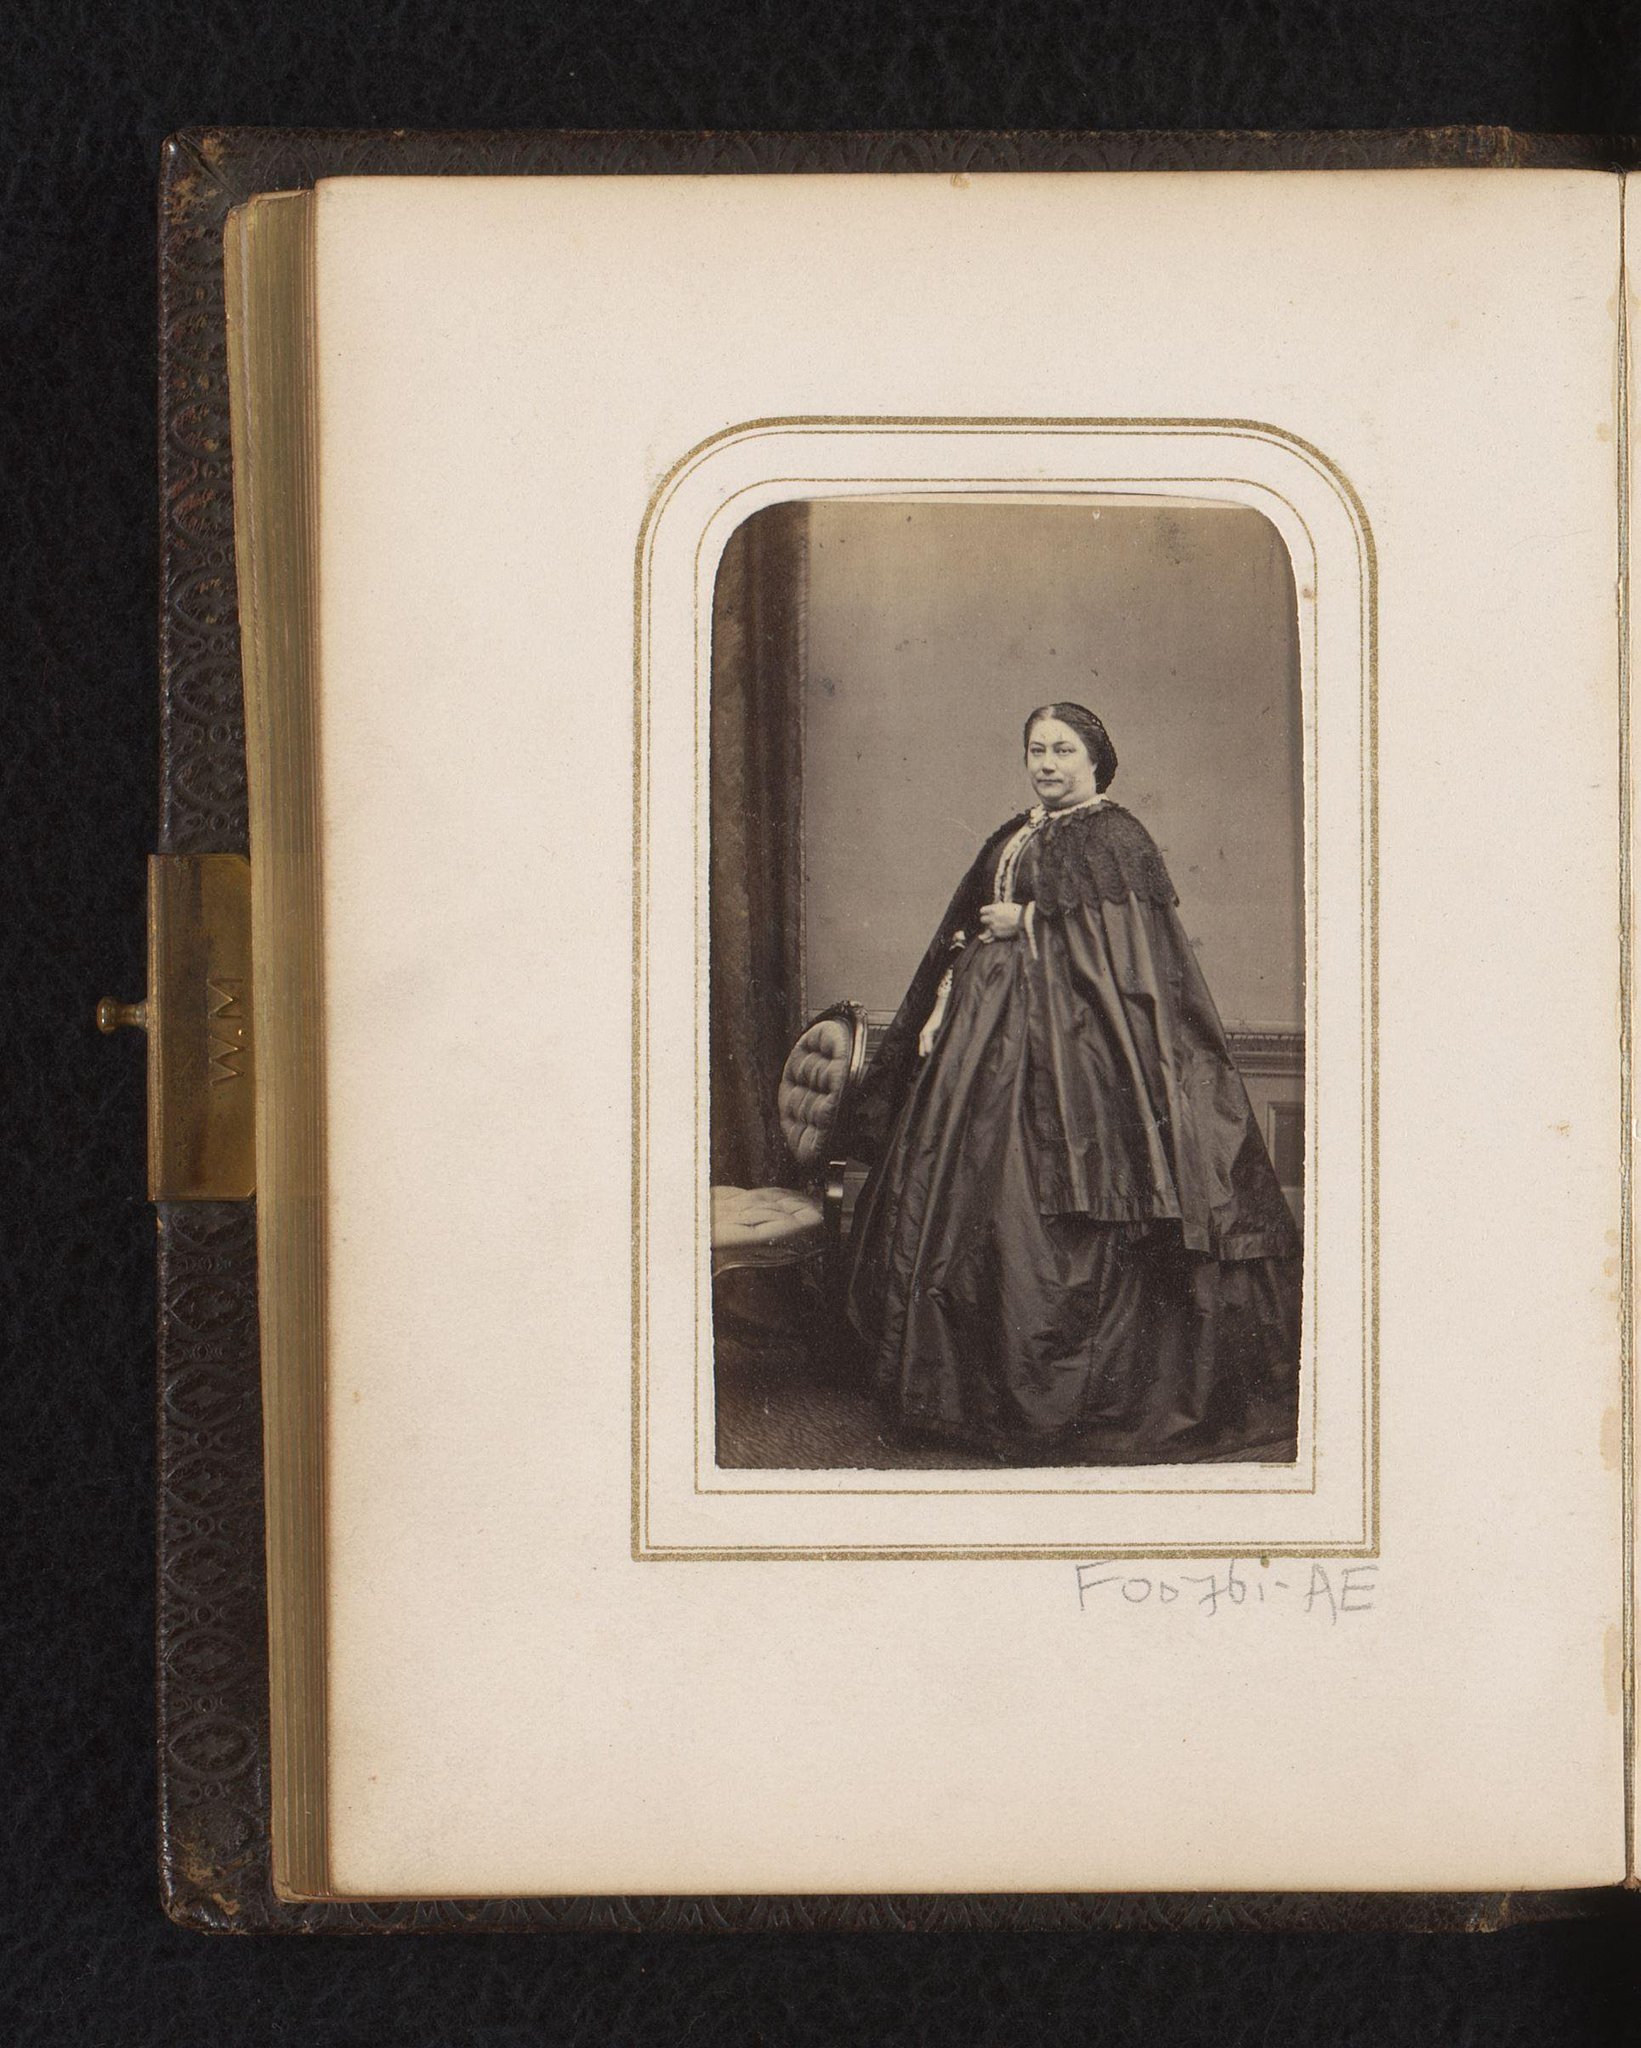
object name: album leaf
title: Portret van een staande vrouw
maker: henry lock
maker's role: fotograaf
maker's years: 1825-1890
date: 1855-1878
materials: cardboard, photographic support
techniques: albumen print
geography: shoreditch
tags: historical persons - bb - woman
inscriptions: inscription: ‘Henry Lock/ Photographen/ 248, Shoreditch’, annotation: ‘died May 19-78’